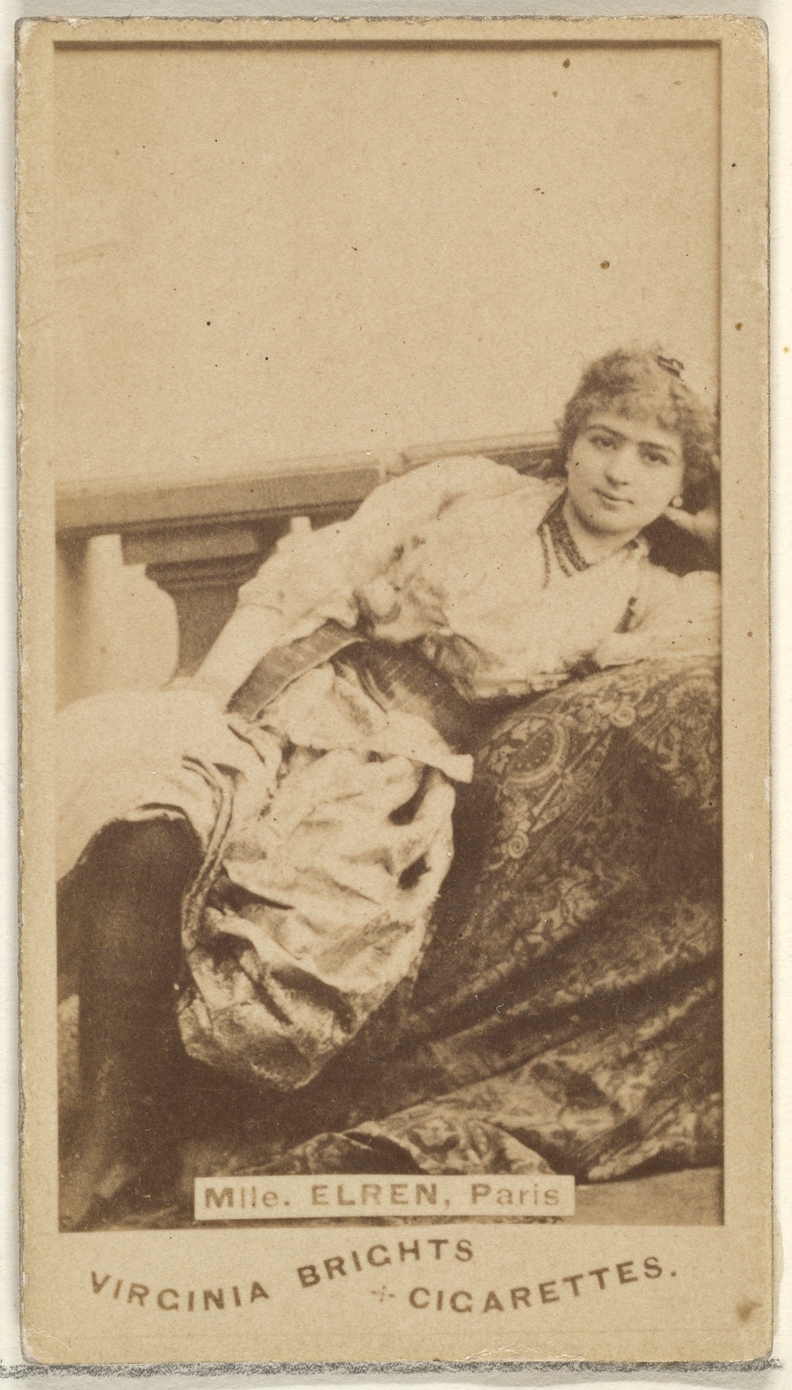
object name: photograph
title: Mlle. Elren, Paris, from the Actors and Actresses series (N45, Type 1) for Virginia Brights Cigarettes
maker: allen & ginter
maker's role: publisher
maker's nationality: american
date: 1888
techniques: albumen silver print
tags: girls,portraits,actresses